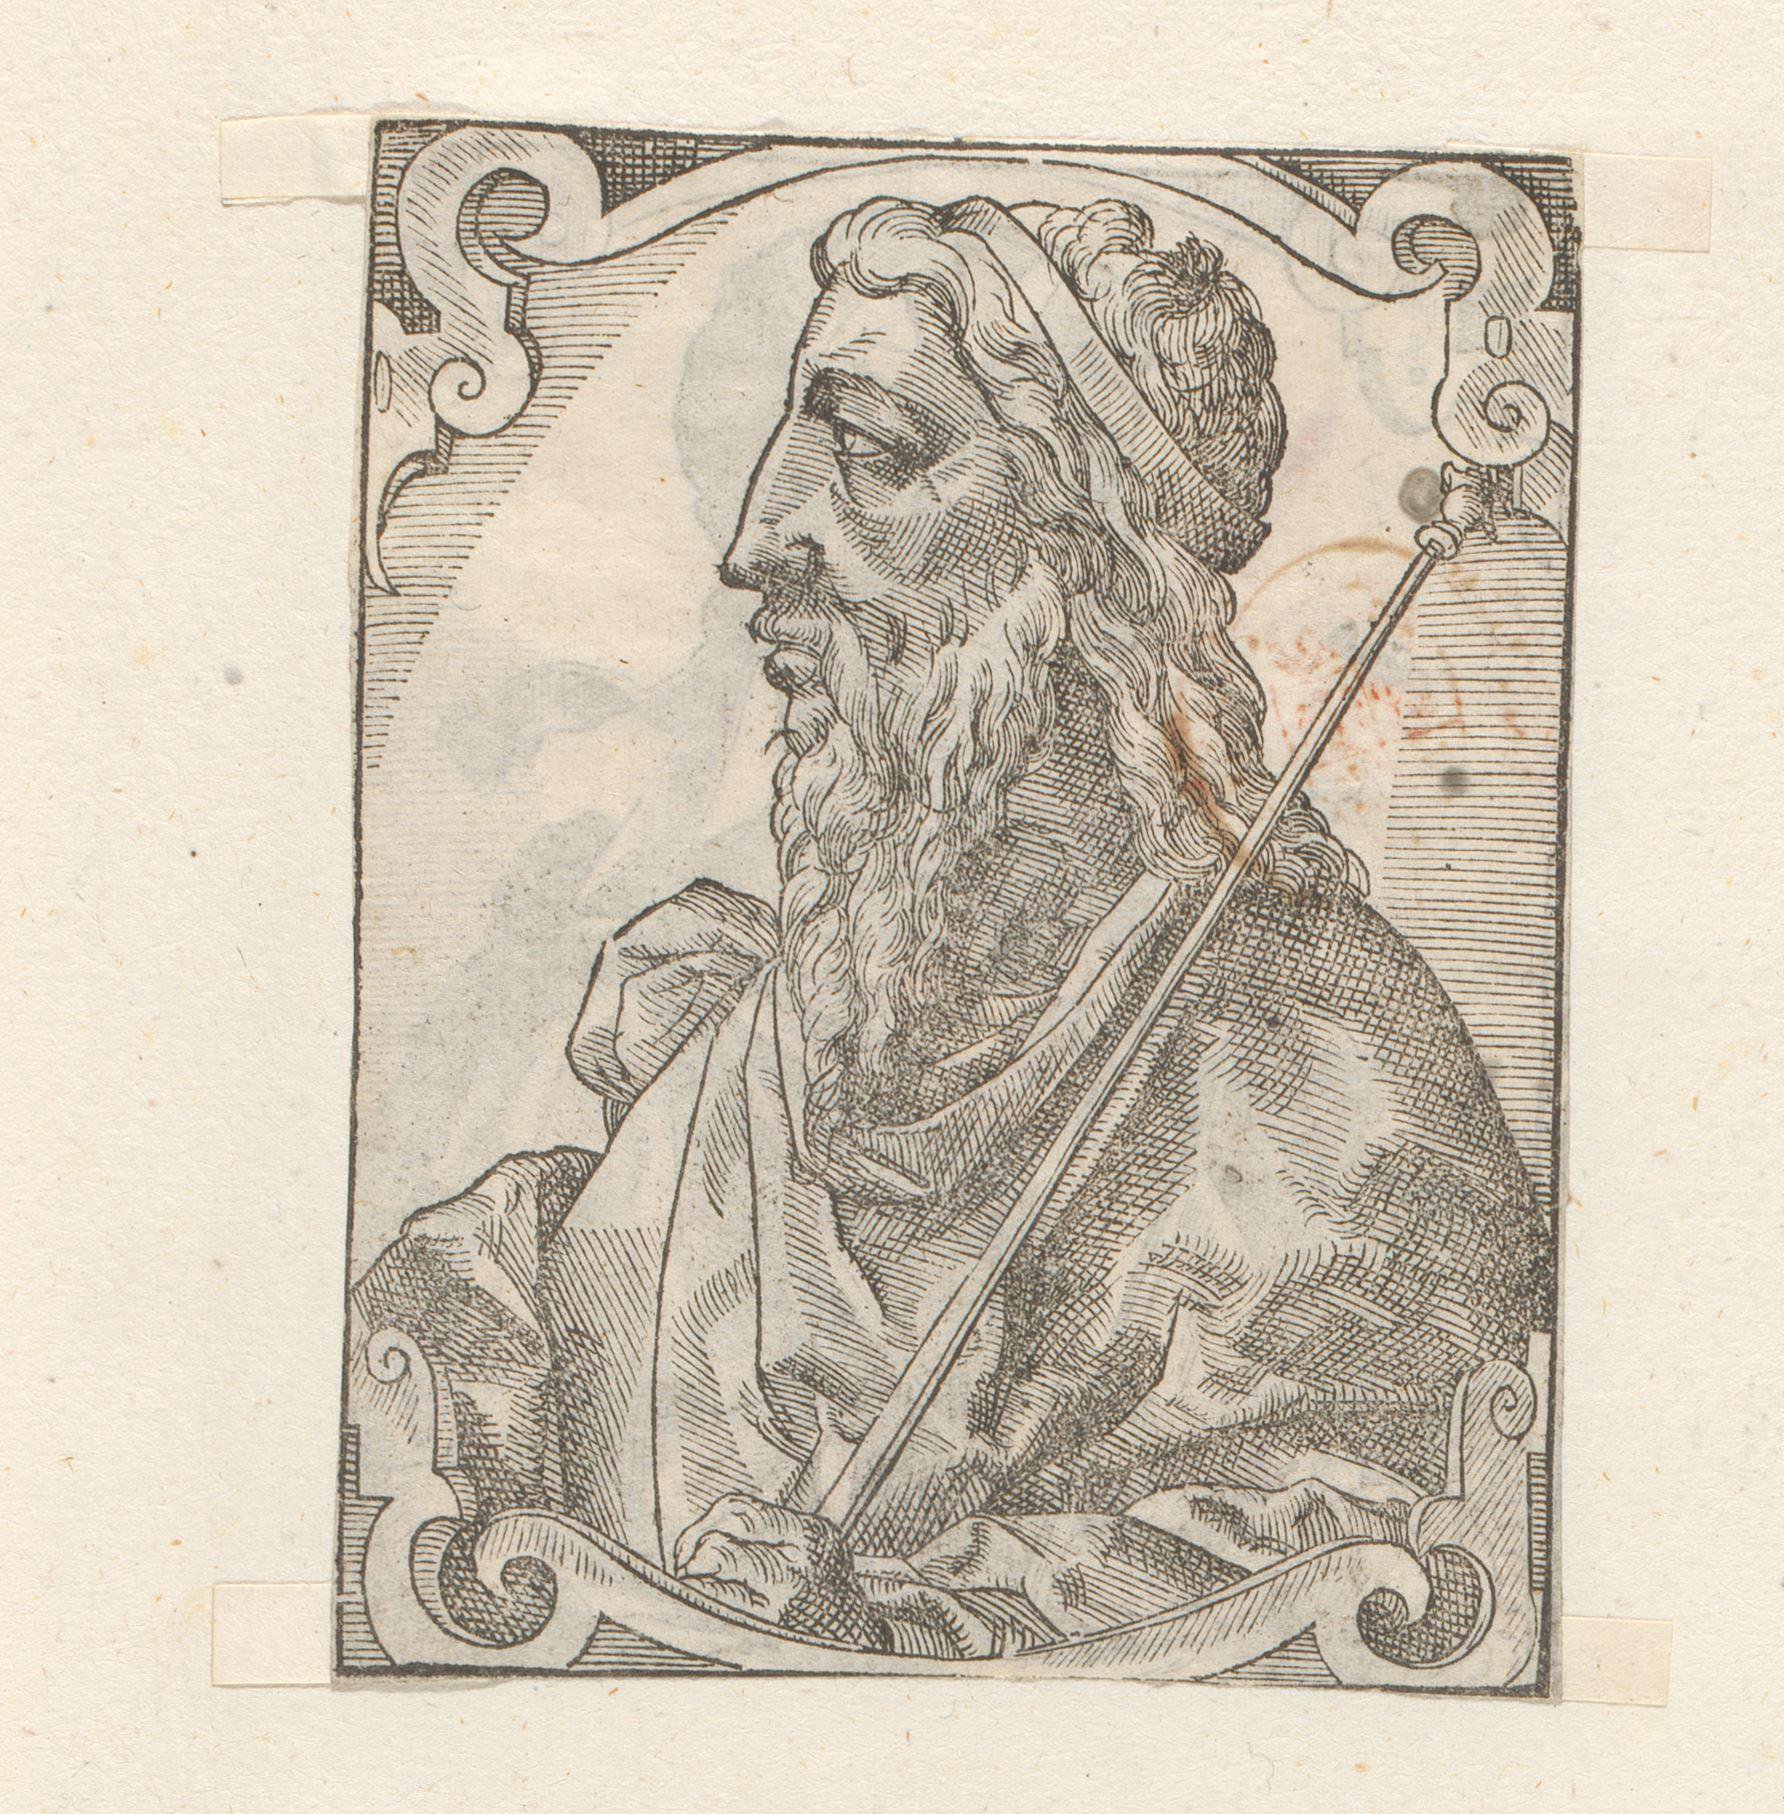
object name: album leaf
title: Romulus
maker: Anonymous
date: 1549-1575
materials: paper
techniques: woodcut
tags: romulus as king of rome, historical persons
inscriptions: collector's mark: Lugt 240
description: Prent gebruikt in: Giovio, Paolo. Elogia Viroum Bellica Virtute Illustrium (…). Bazel: Peter Perna, 1575.